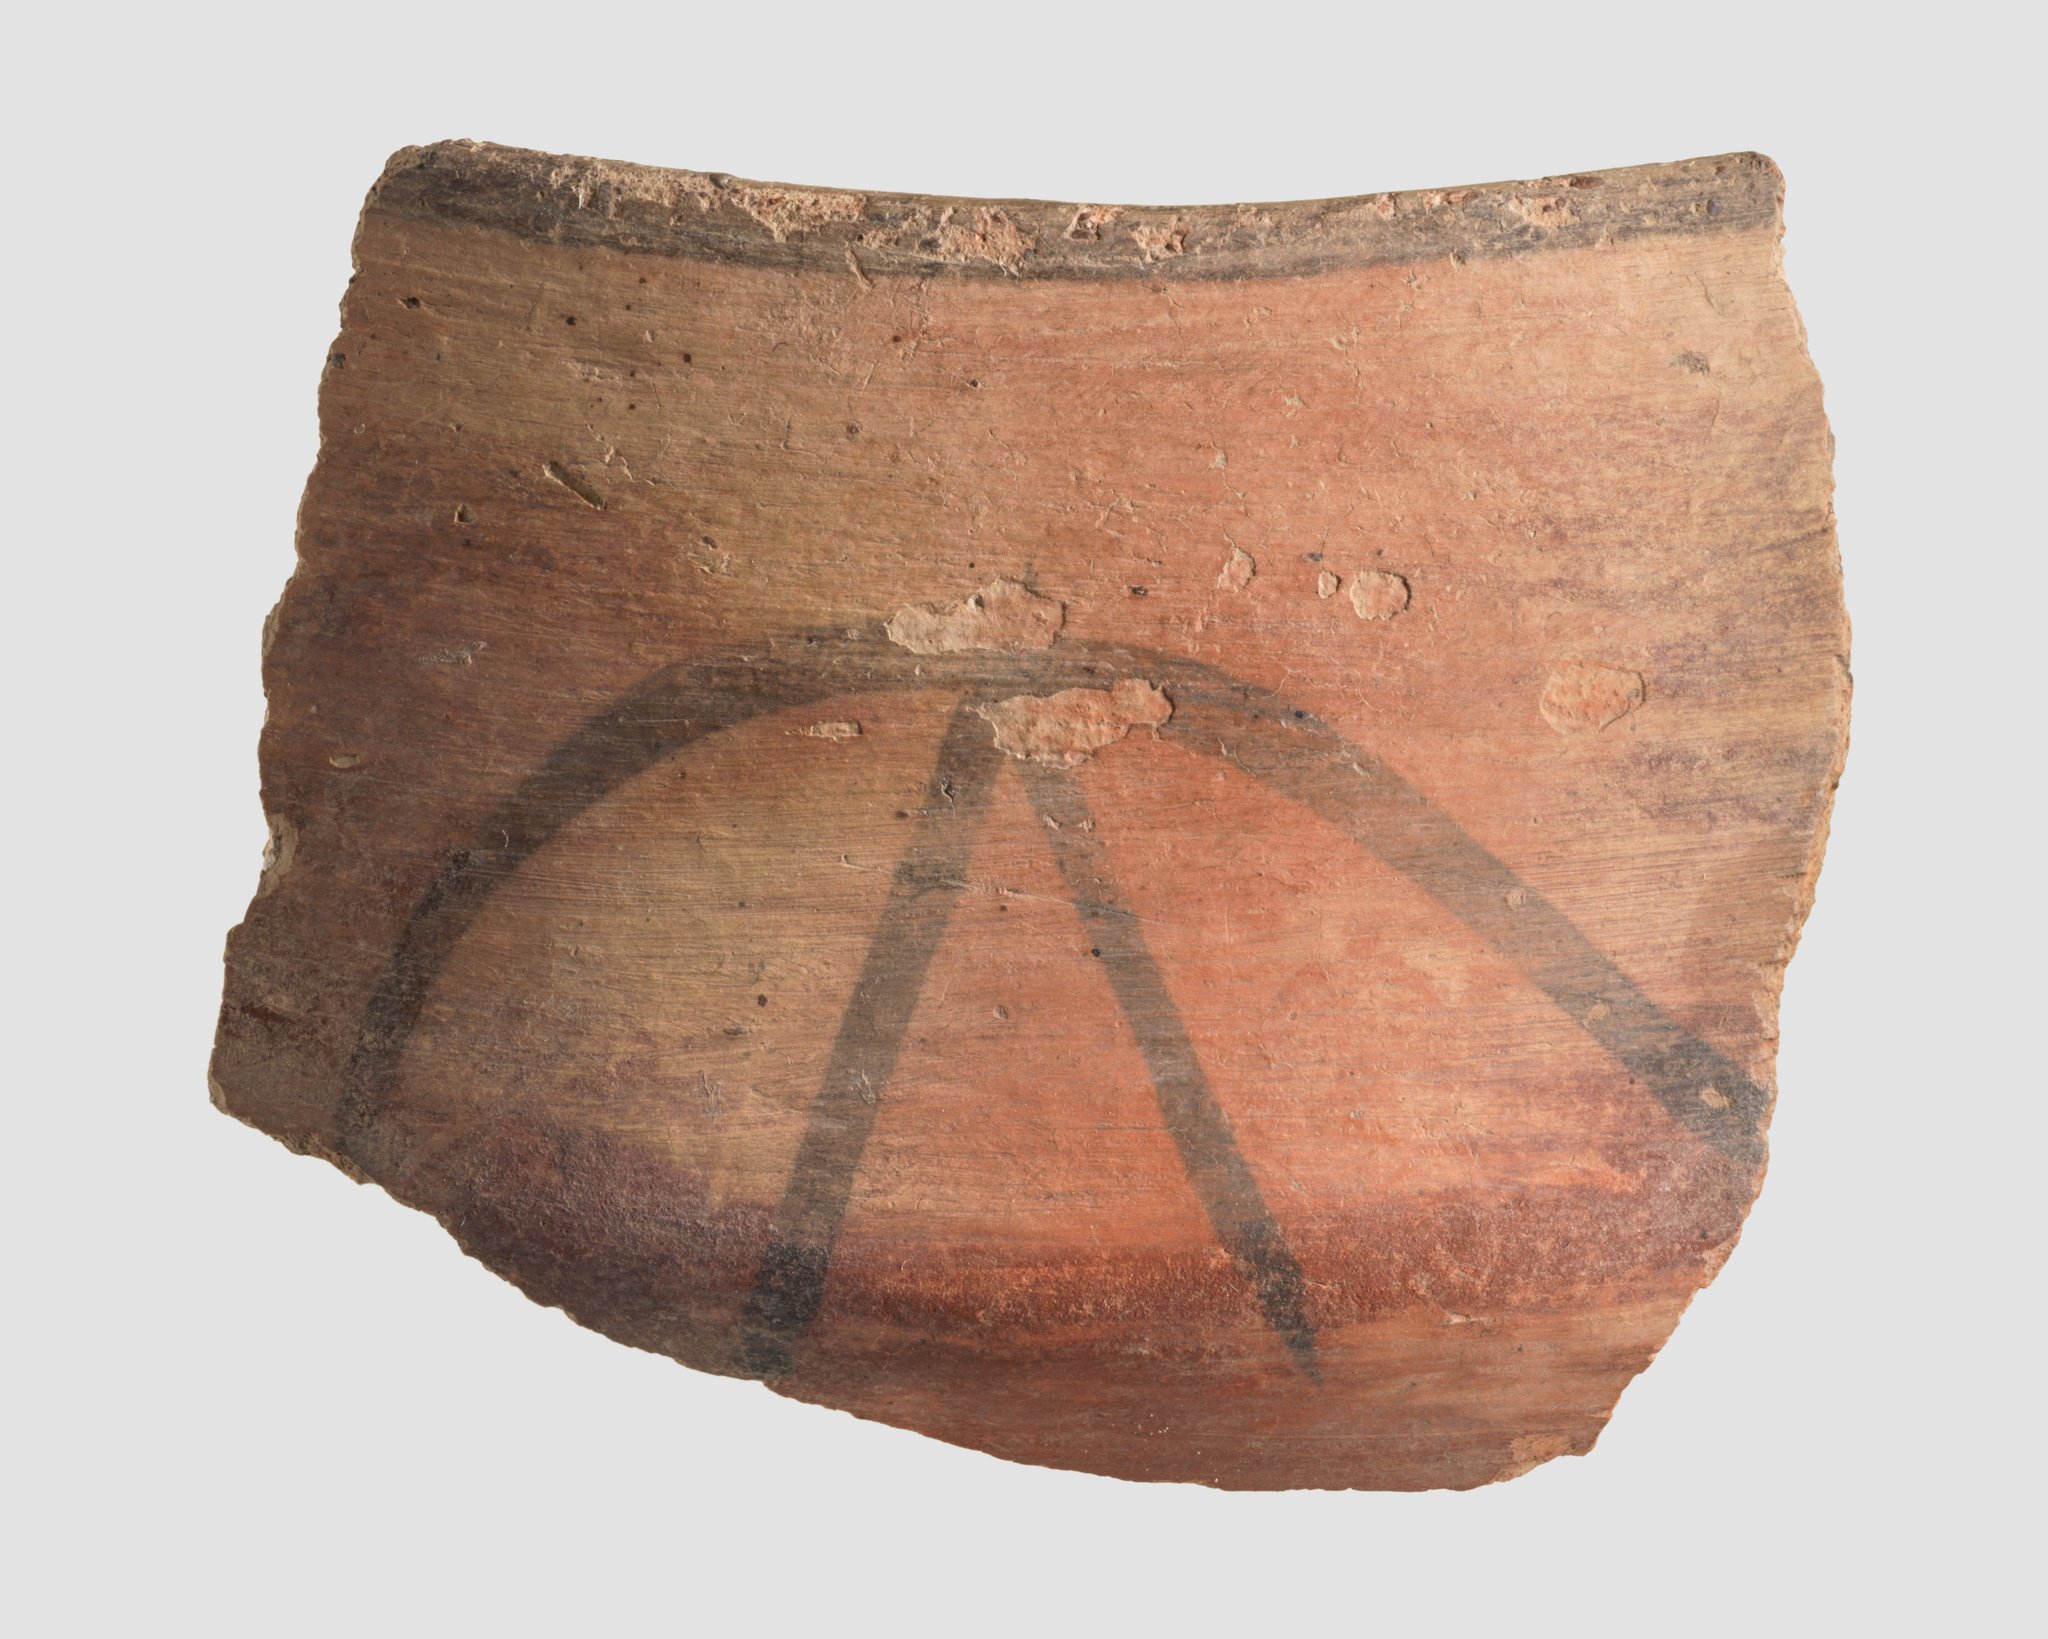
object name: sherd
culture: iranian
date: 3500-3100 BCE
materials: ceramic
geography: iran